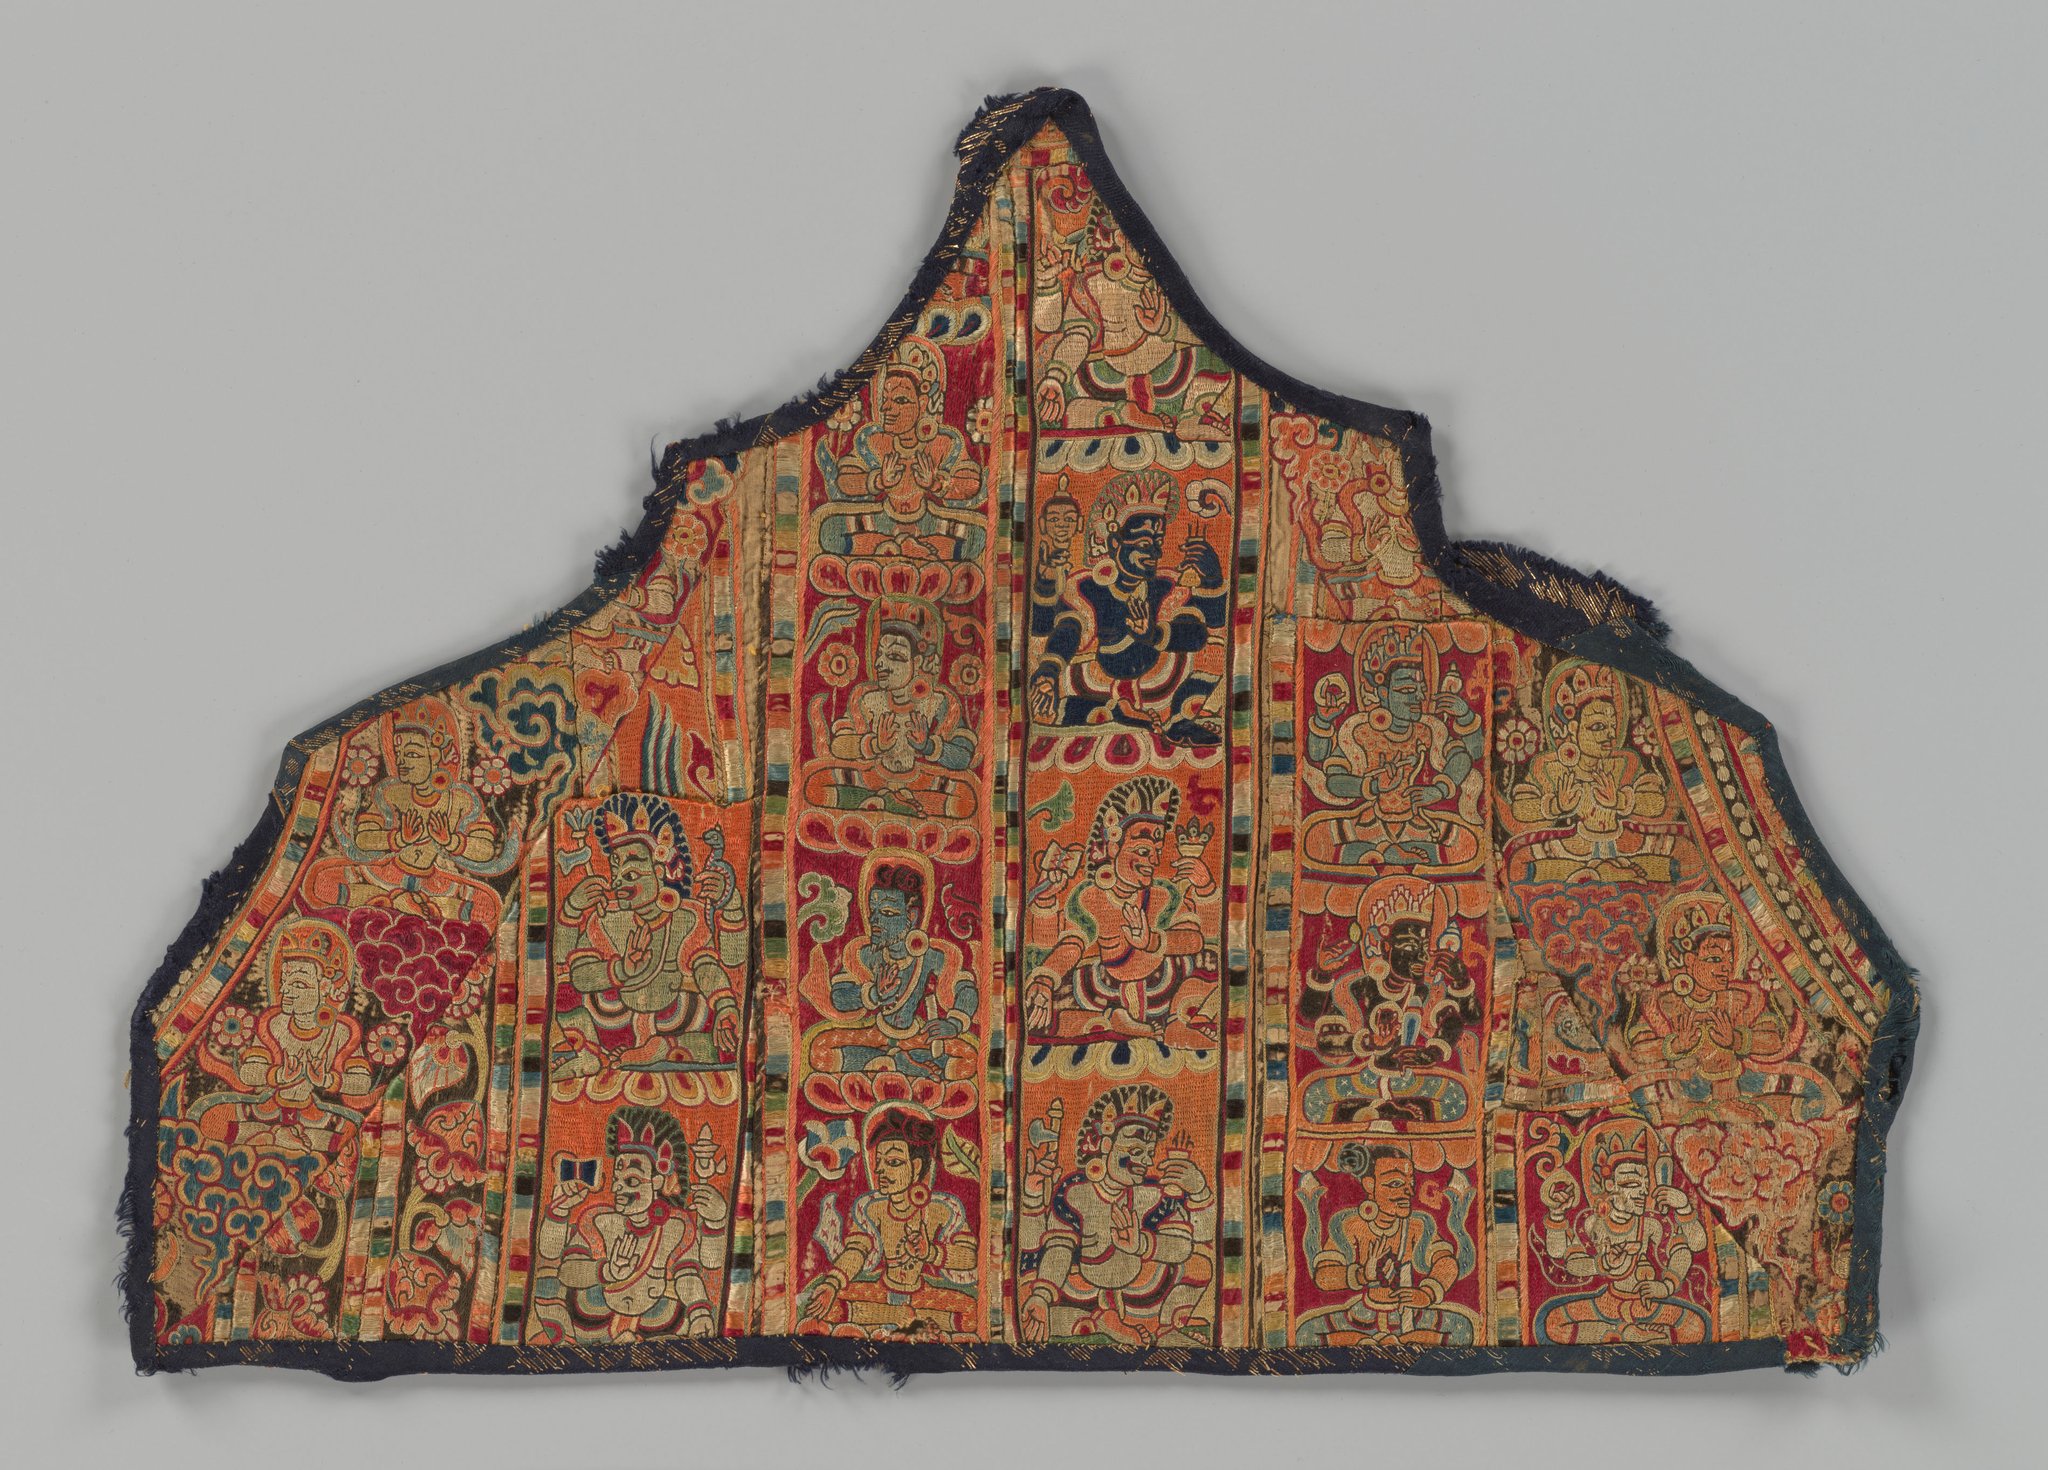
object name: temple banner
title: Temple banner with Brahmanical deities and ascetics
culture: nepali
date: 1401-1433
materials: cotton, silk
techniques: embroidery